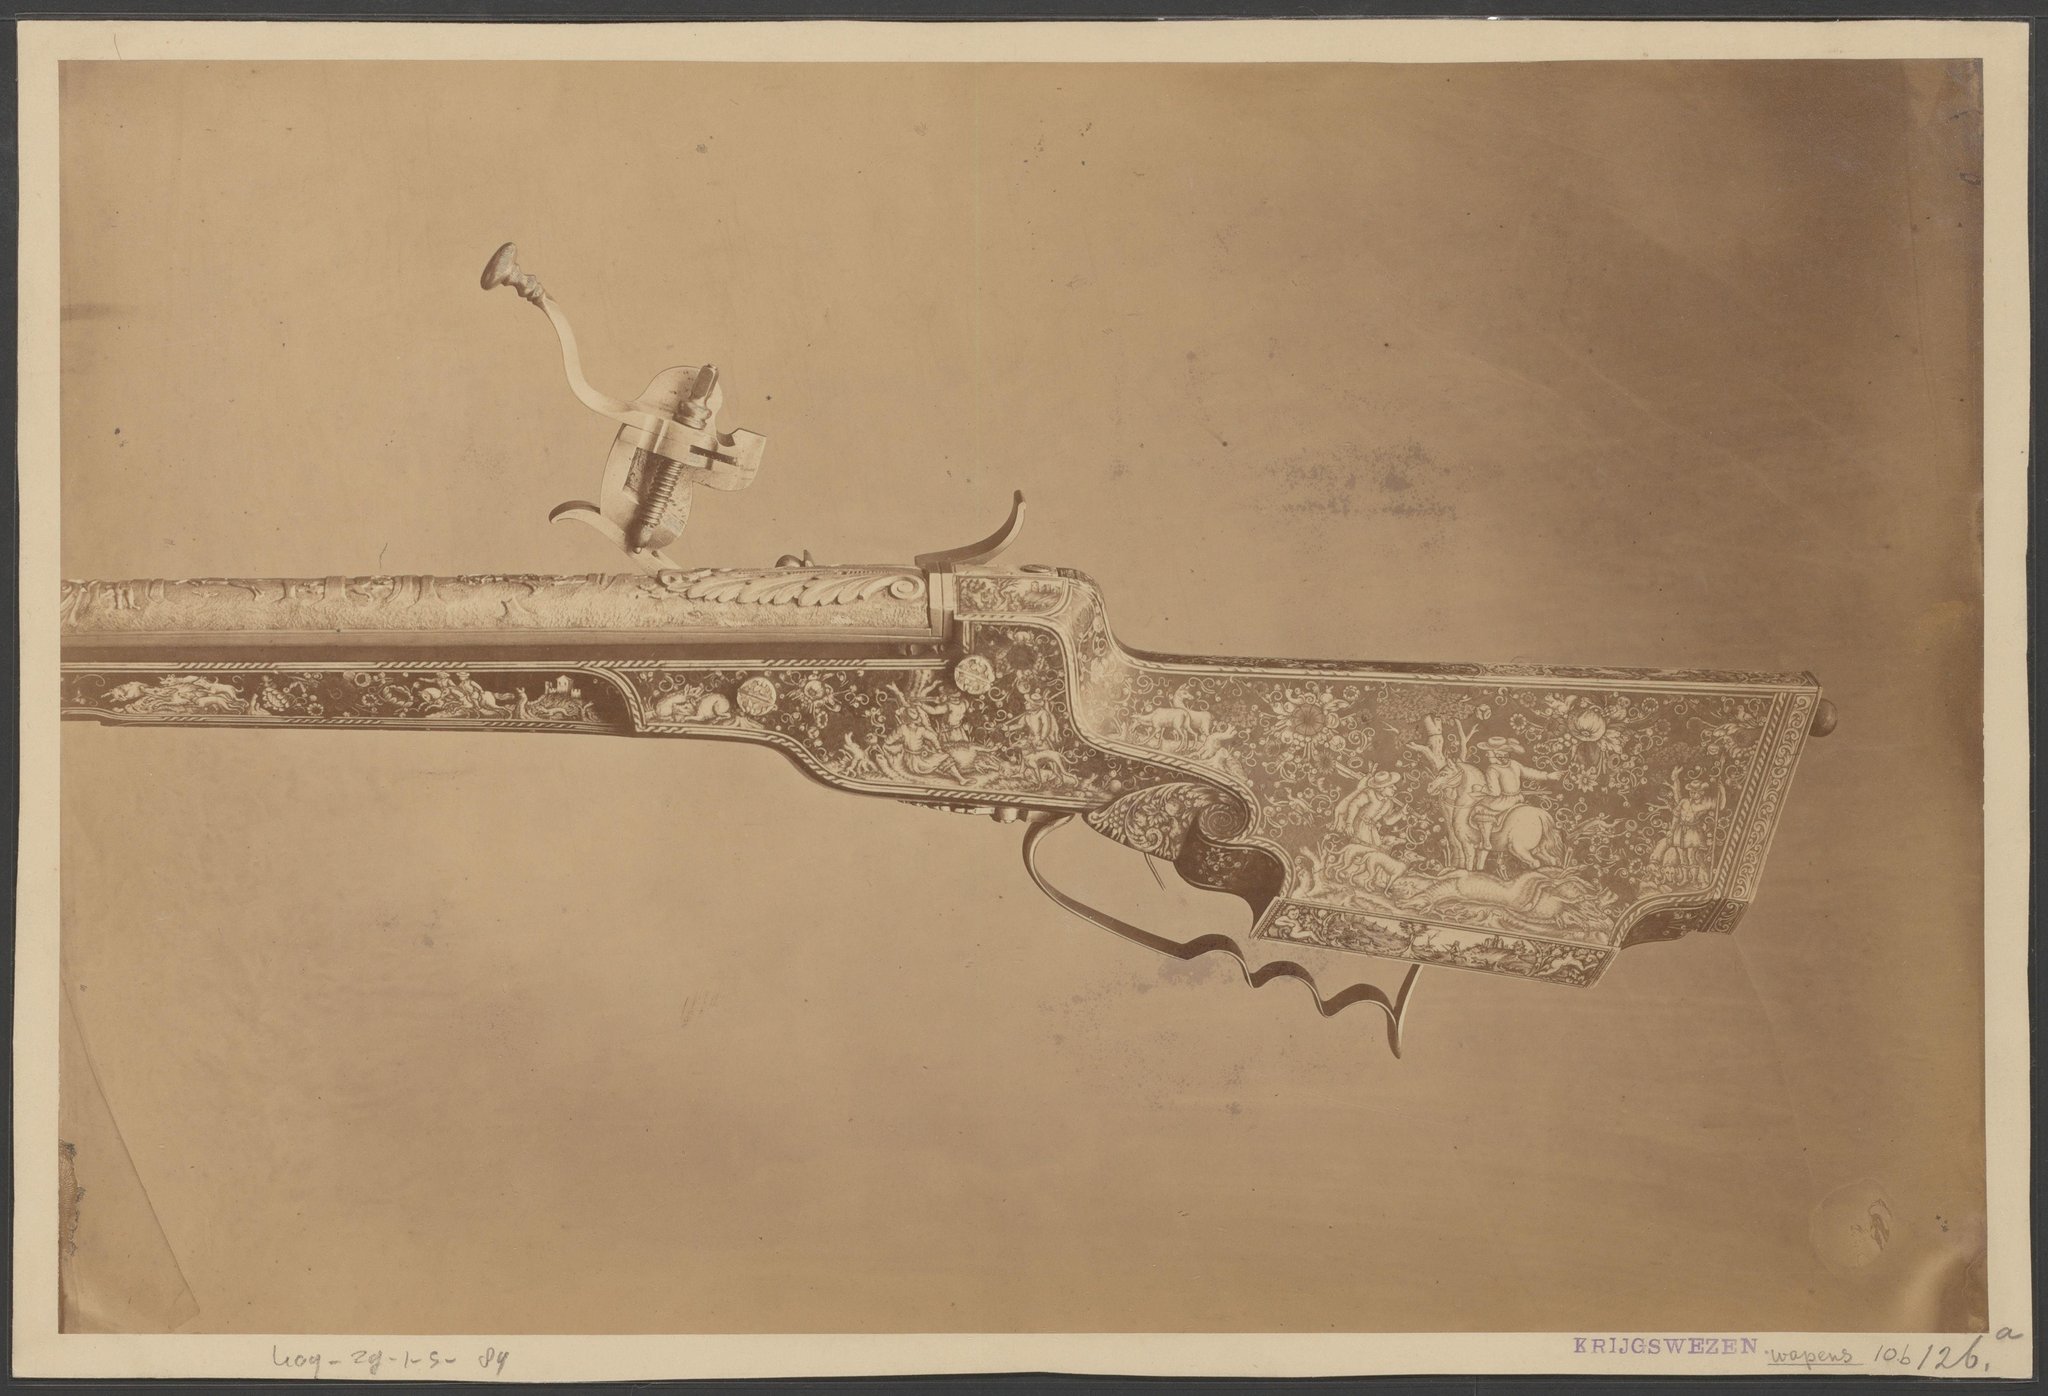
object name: photograph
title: Kolf van een radslotgeweer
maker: Anonymous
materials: cardboard, paper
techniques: albumen print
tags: hoofed animals: deer, firearms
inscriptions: stamp, collector's mark: Lugt 1641, stamp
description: Op de kolf staat een ruiter te paard bij een geschoten hert. Onderwerpsrubrieken binnen de Atlas Zeden en Gewoonten: Krijgswezen, Wapens.